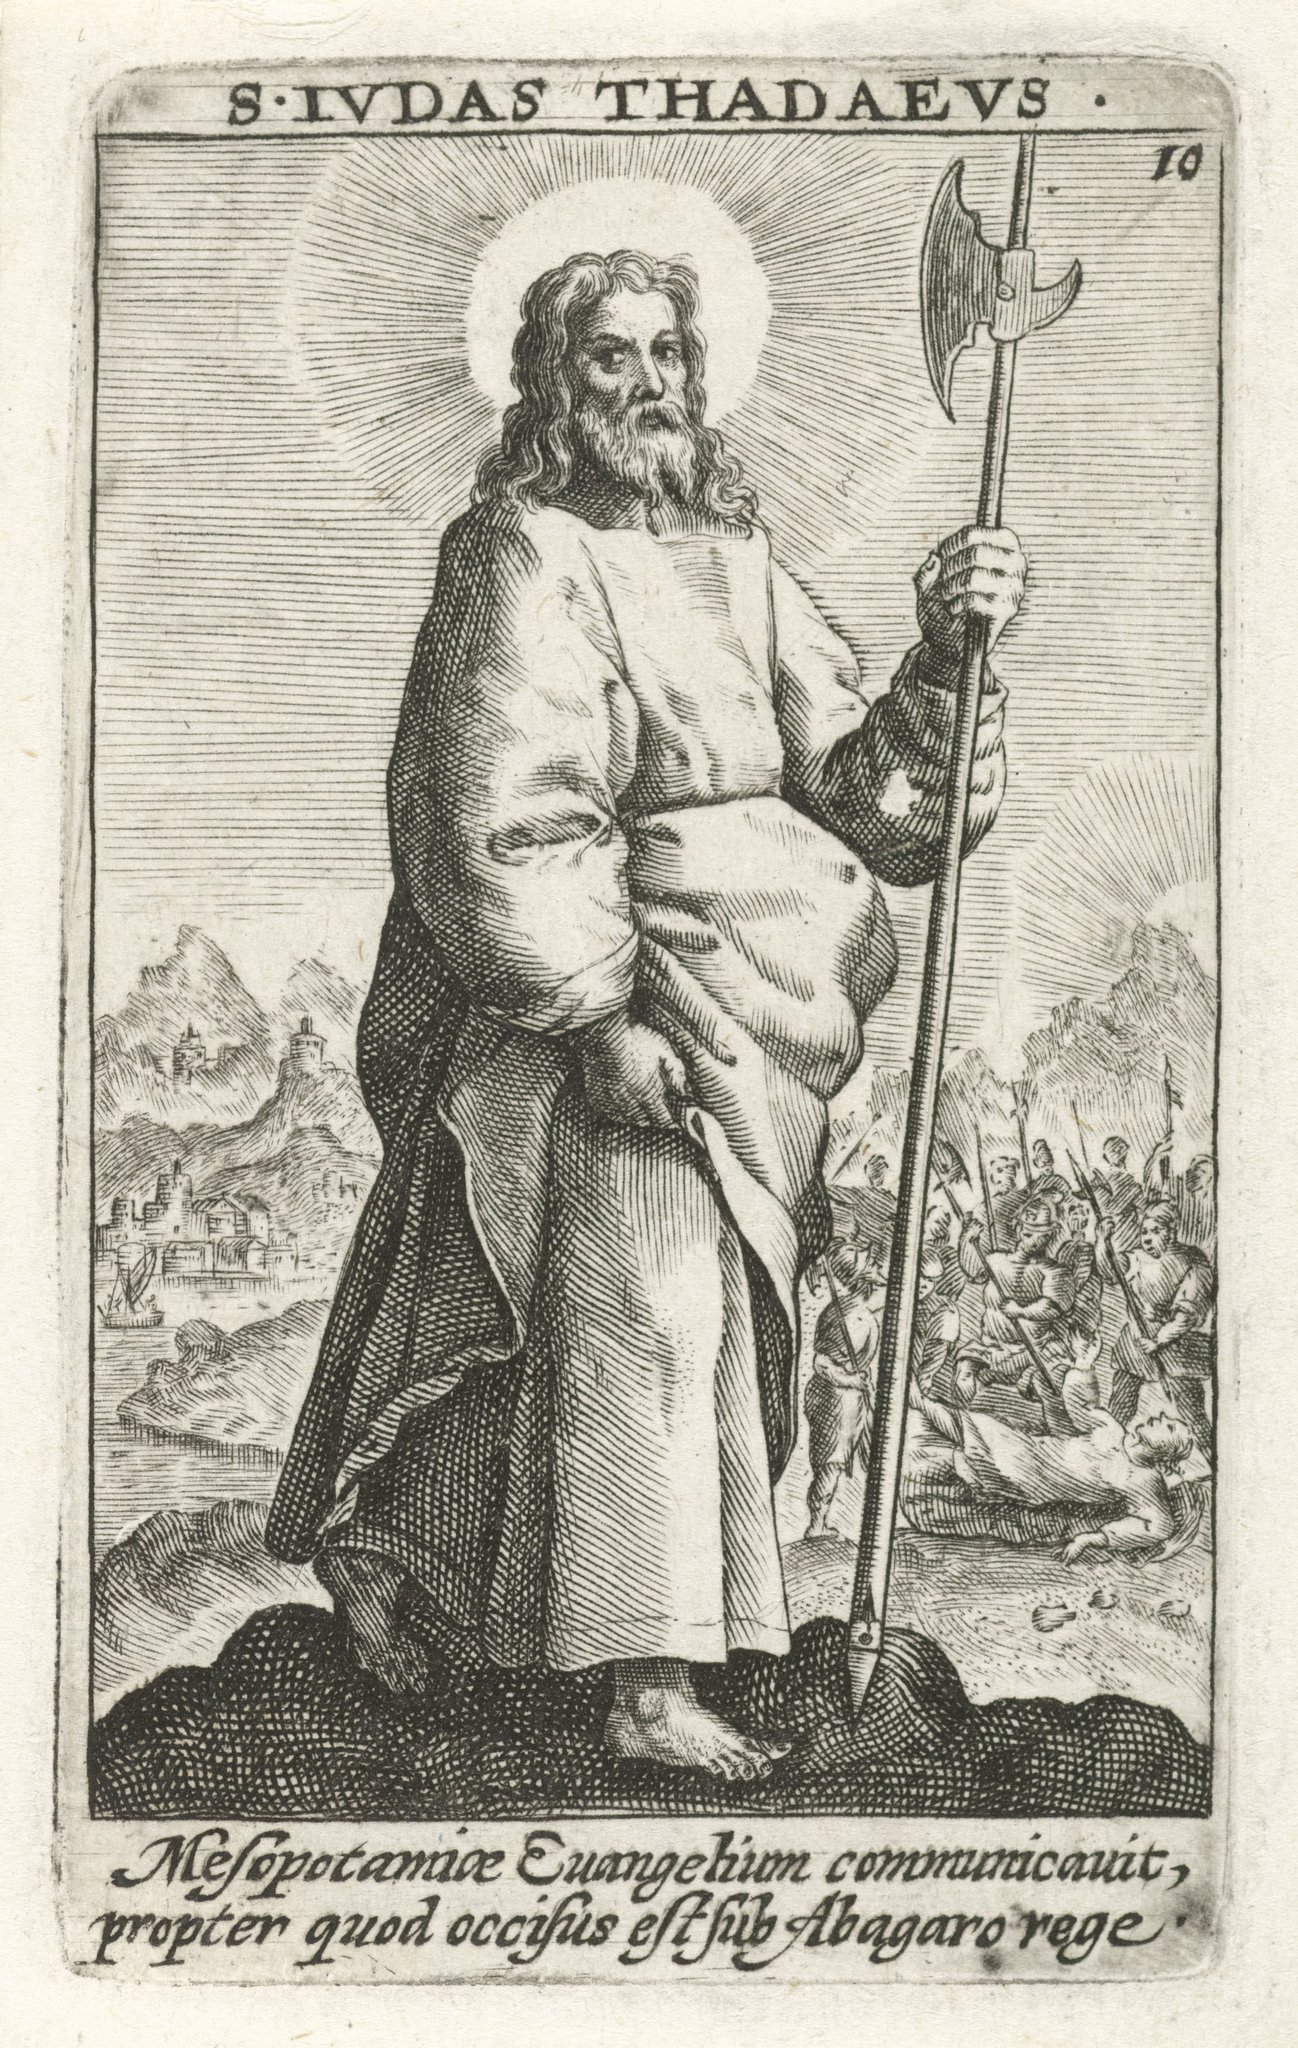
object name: print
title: De twaalf apostelen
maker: crispijn van de passe (i)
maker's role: draughtsman, print maker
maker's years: 1564-1637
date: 1574-1637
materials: paper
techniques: engraving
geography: cologne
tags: the apostle jude thaddaeus; possible attributes: book, club, halberd, scroll, the apostle jude thaddaeus; possible attributes: book, club, halberd, scroll - martyrdom, suffering, misfortune, death of male saint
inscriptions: collector's mark: Lugt 240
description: De apostel Judas Thaddeüs, ten voeten uit, een hellebaard in zijn linkerhand. Op de achtergrond wordt hij gemarteld. In de marge een onderschrift in het Latijn. Prent uit een serie met de twaalf apostelen.